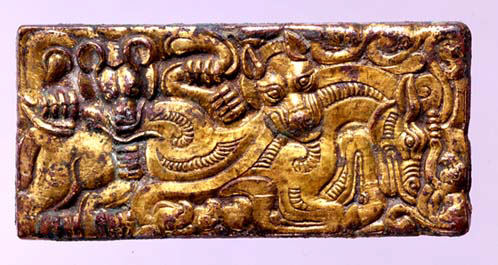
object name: belt buckle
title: Belt Buckle with Animal-Combat Scene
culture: north chinese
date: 300-101 BCE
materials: bronze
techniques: gilding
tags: animals